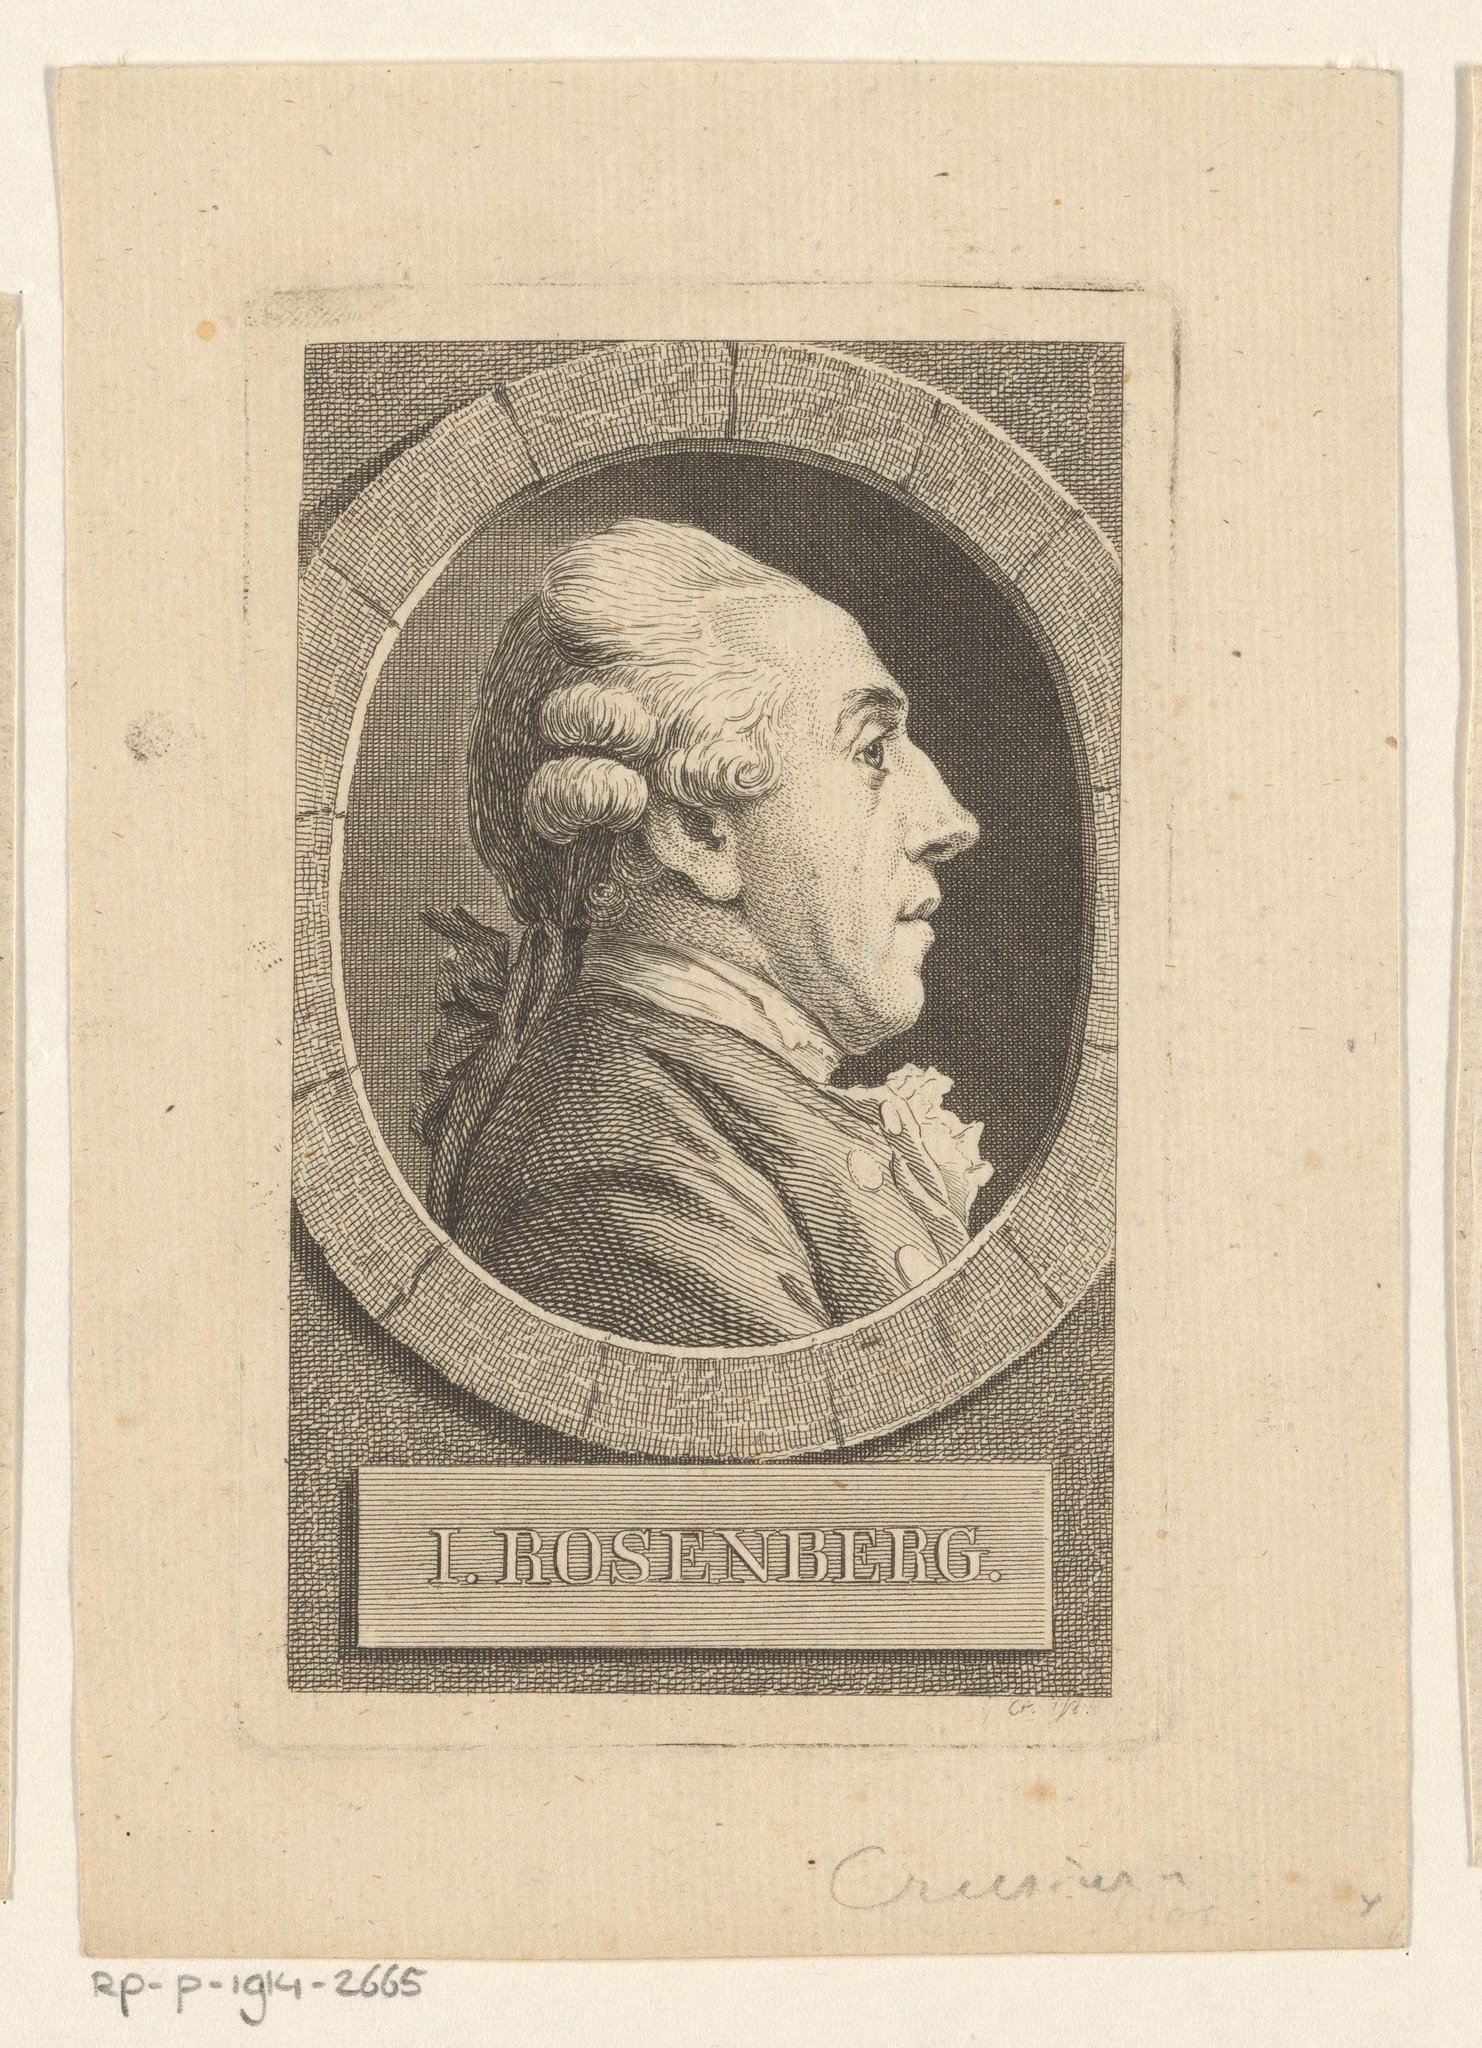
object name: print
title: I. Rosenberg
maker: gottlieb leberecht crusius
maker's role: print maker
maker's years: 1730-1804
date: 1749-1804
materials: paper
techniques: engraving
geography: leipzig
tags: berlin, painter, print maker, historical persons, portrait, self-portrait of painter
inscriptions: collector's mark: Lugt 2228